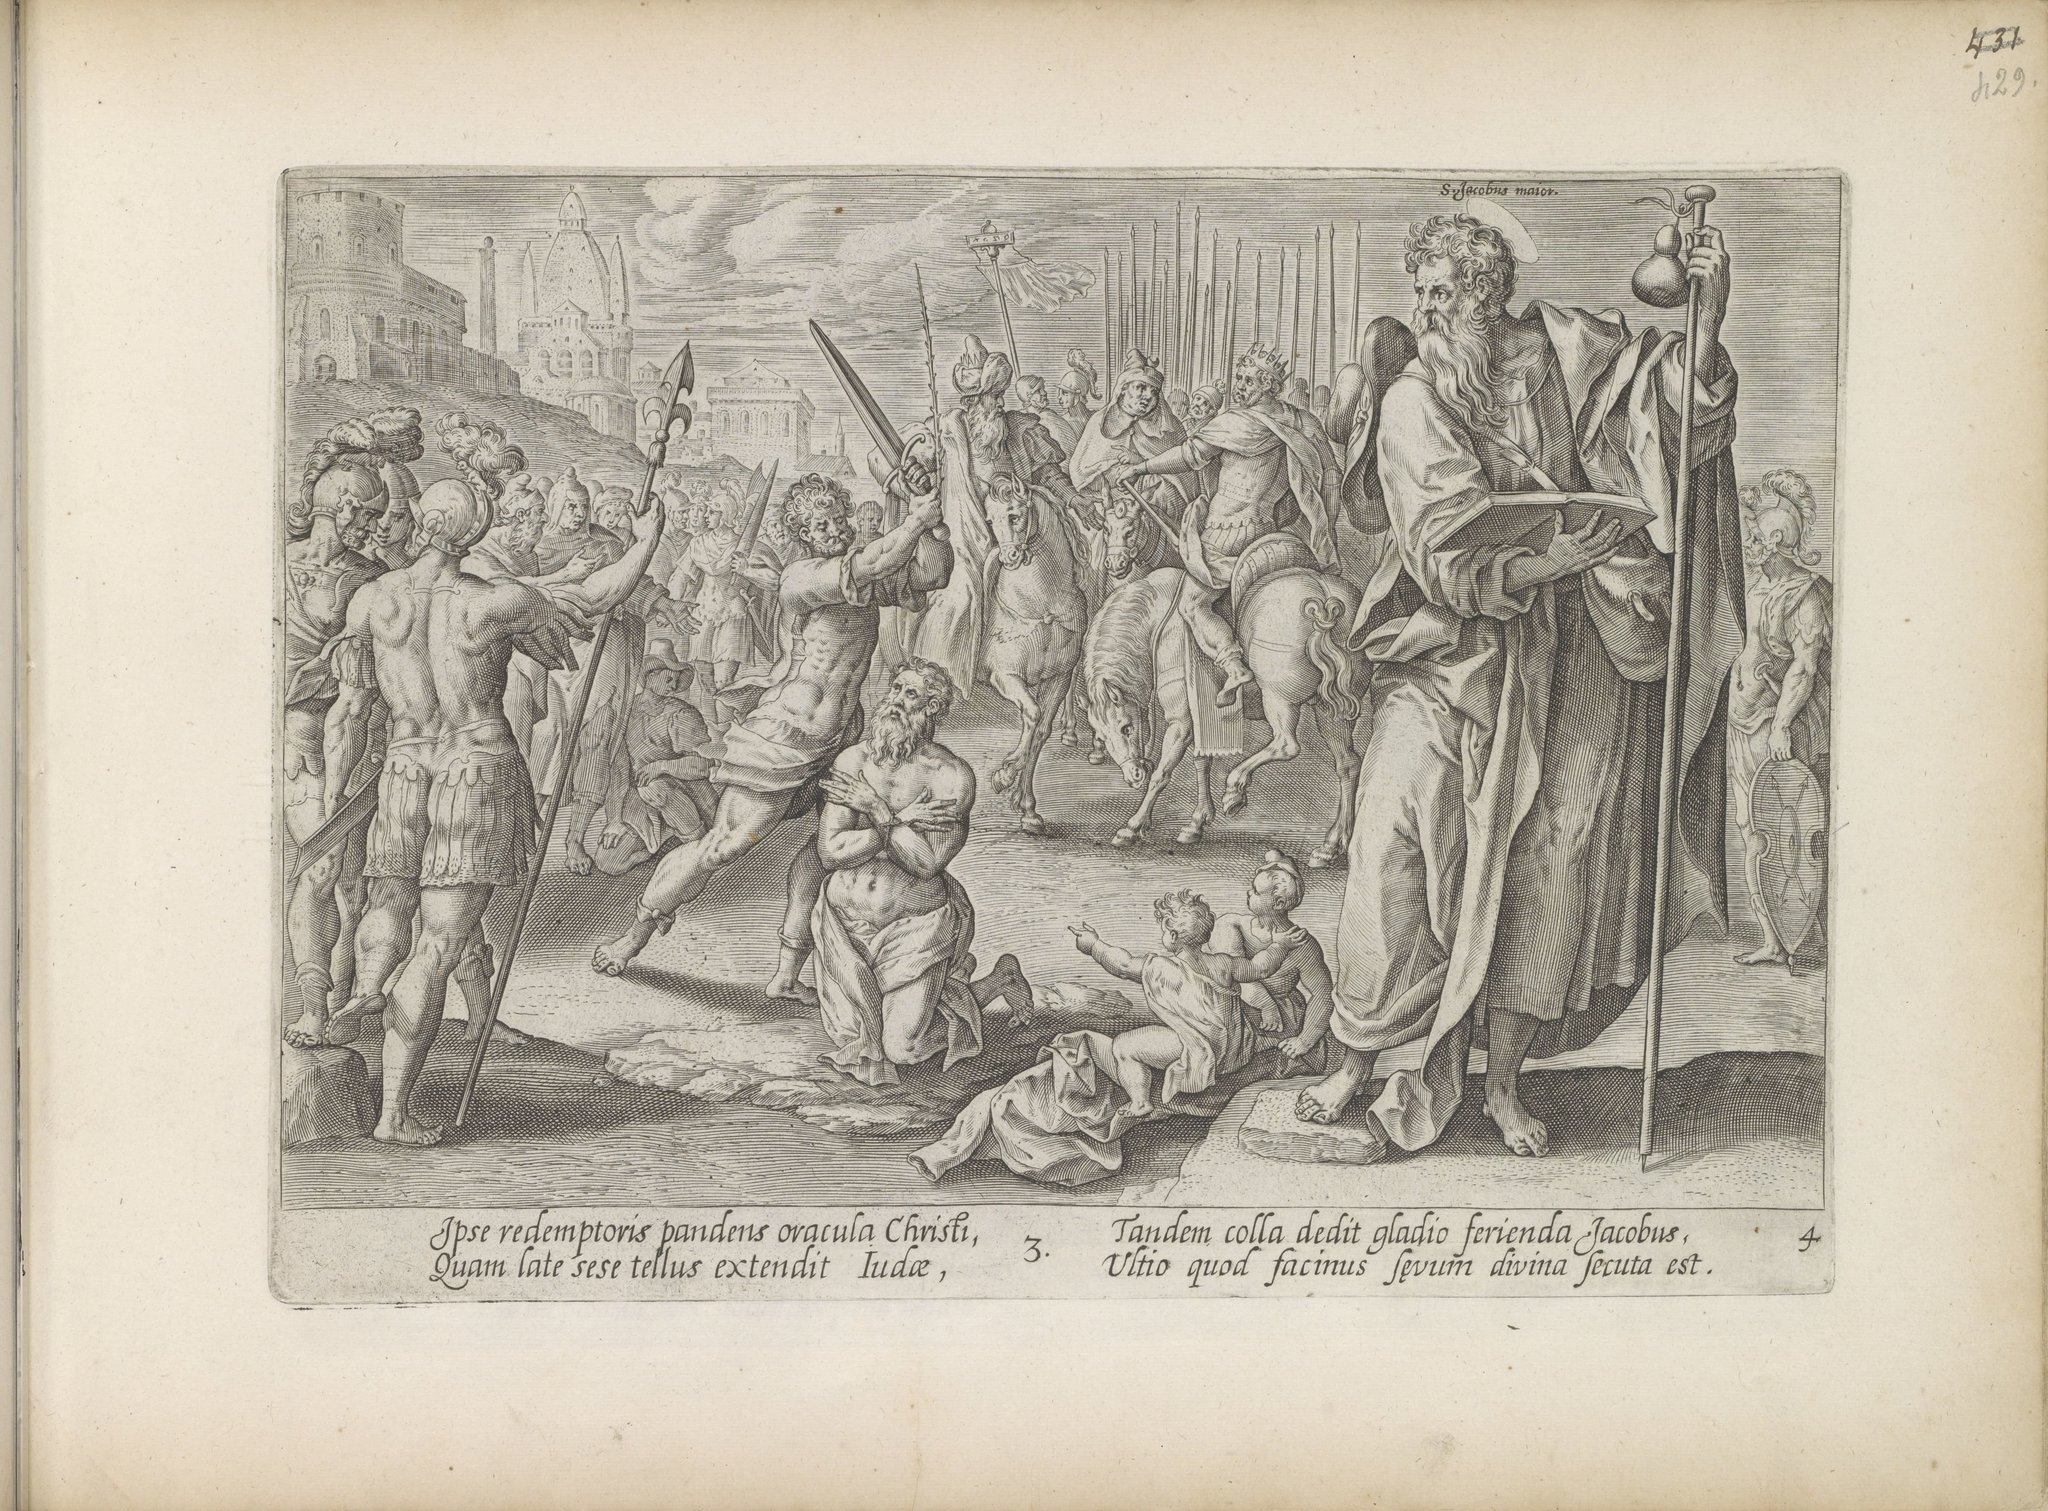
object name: print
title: Theatrum Biblicum Hoc Est Historiae Sacrae Veteris et Novi Testamenti Tabulis Aeneis Expressae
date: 1576-1580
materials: paper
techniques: engraving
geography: amsterdam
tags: beheading of james, the apostle james the great; possible attributes: book, pilgrim's cloak, hat, shell, staff, and wallet, scroll, sword - martyrdom, suffering, misfortune, death of male saint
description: Jakobus de Meerdere wordt onthoofd met een zwaard; rechts naast het tafereel van zijn marteldood staat hij nogmaals afgebeeld, met een pelgrimsstaf in de hand waaraan een kalebasfles bungelt. Onder de voorstelling een verklarende tekst in het Latijn. Deze prent maakt deel uit van een album.